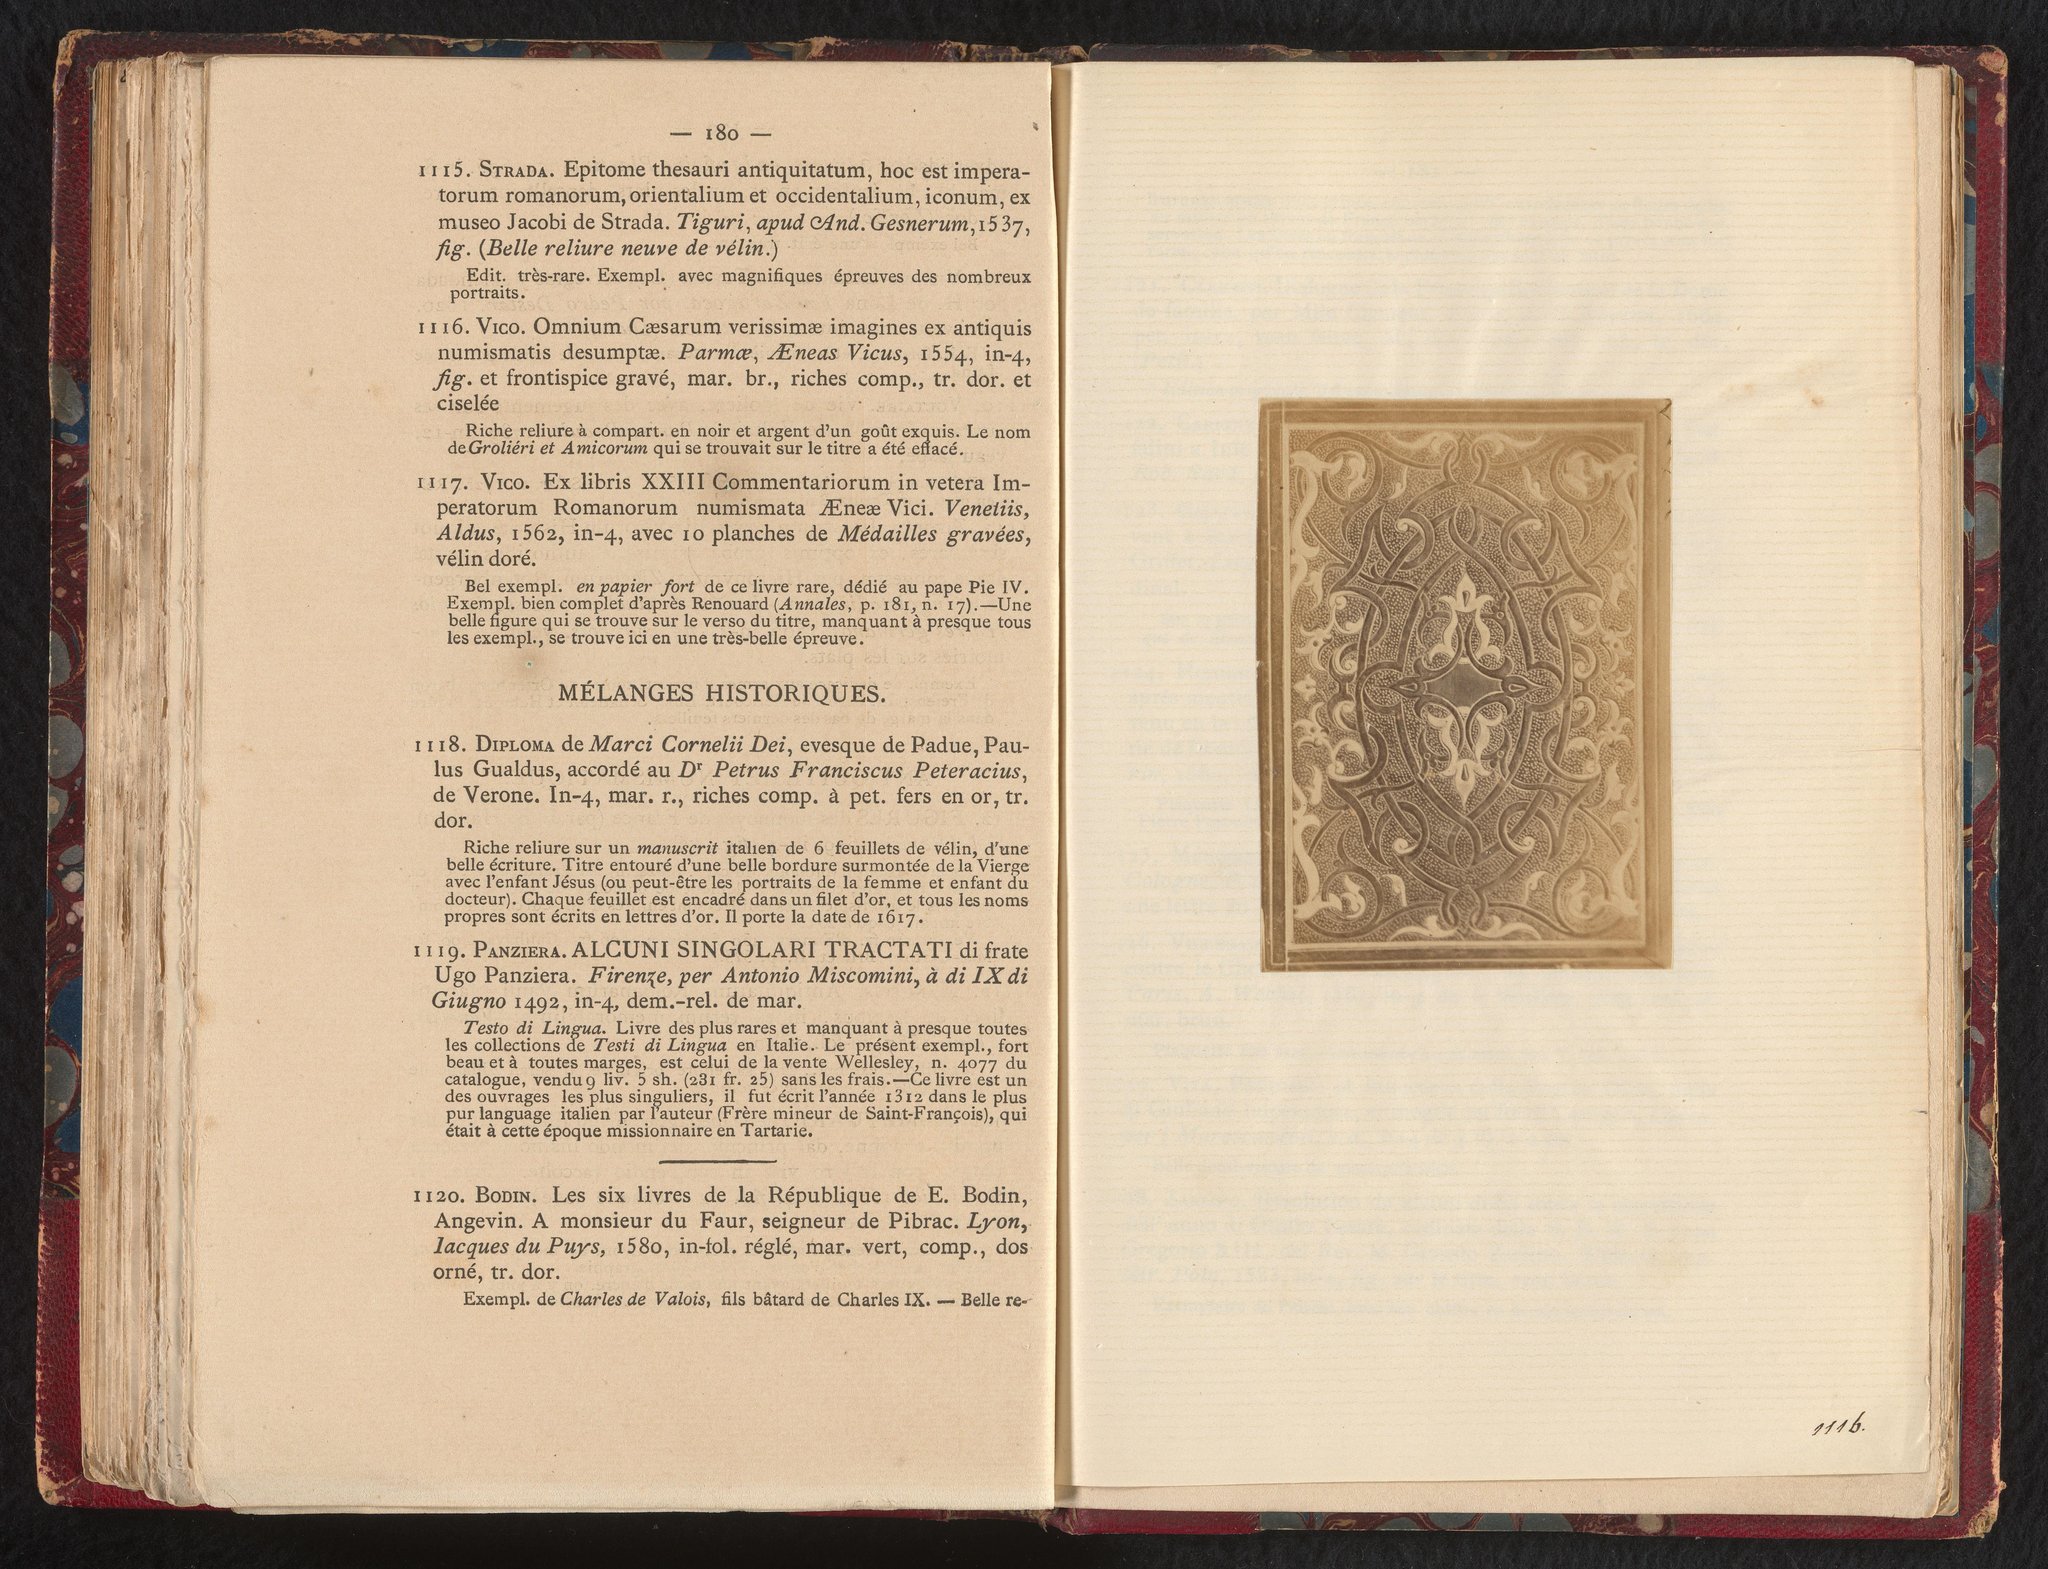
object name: page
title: Fotoreproductie van boekomslag van Omnium Caesarum verissimae imagines ex antiquis numismatis desumptae uit 1554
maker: Anonymous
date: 1863-1868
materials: paper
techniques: albumen print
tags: book-cover, binding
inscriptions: number: ‘1116’